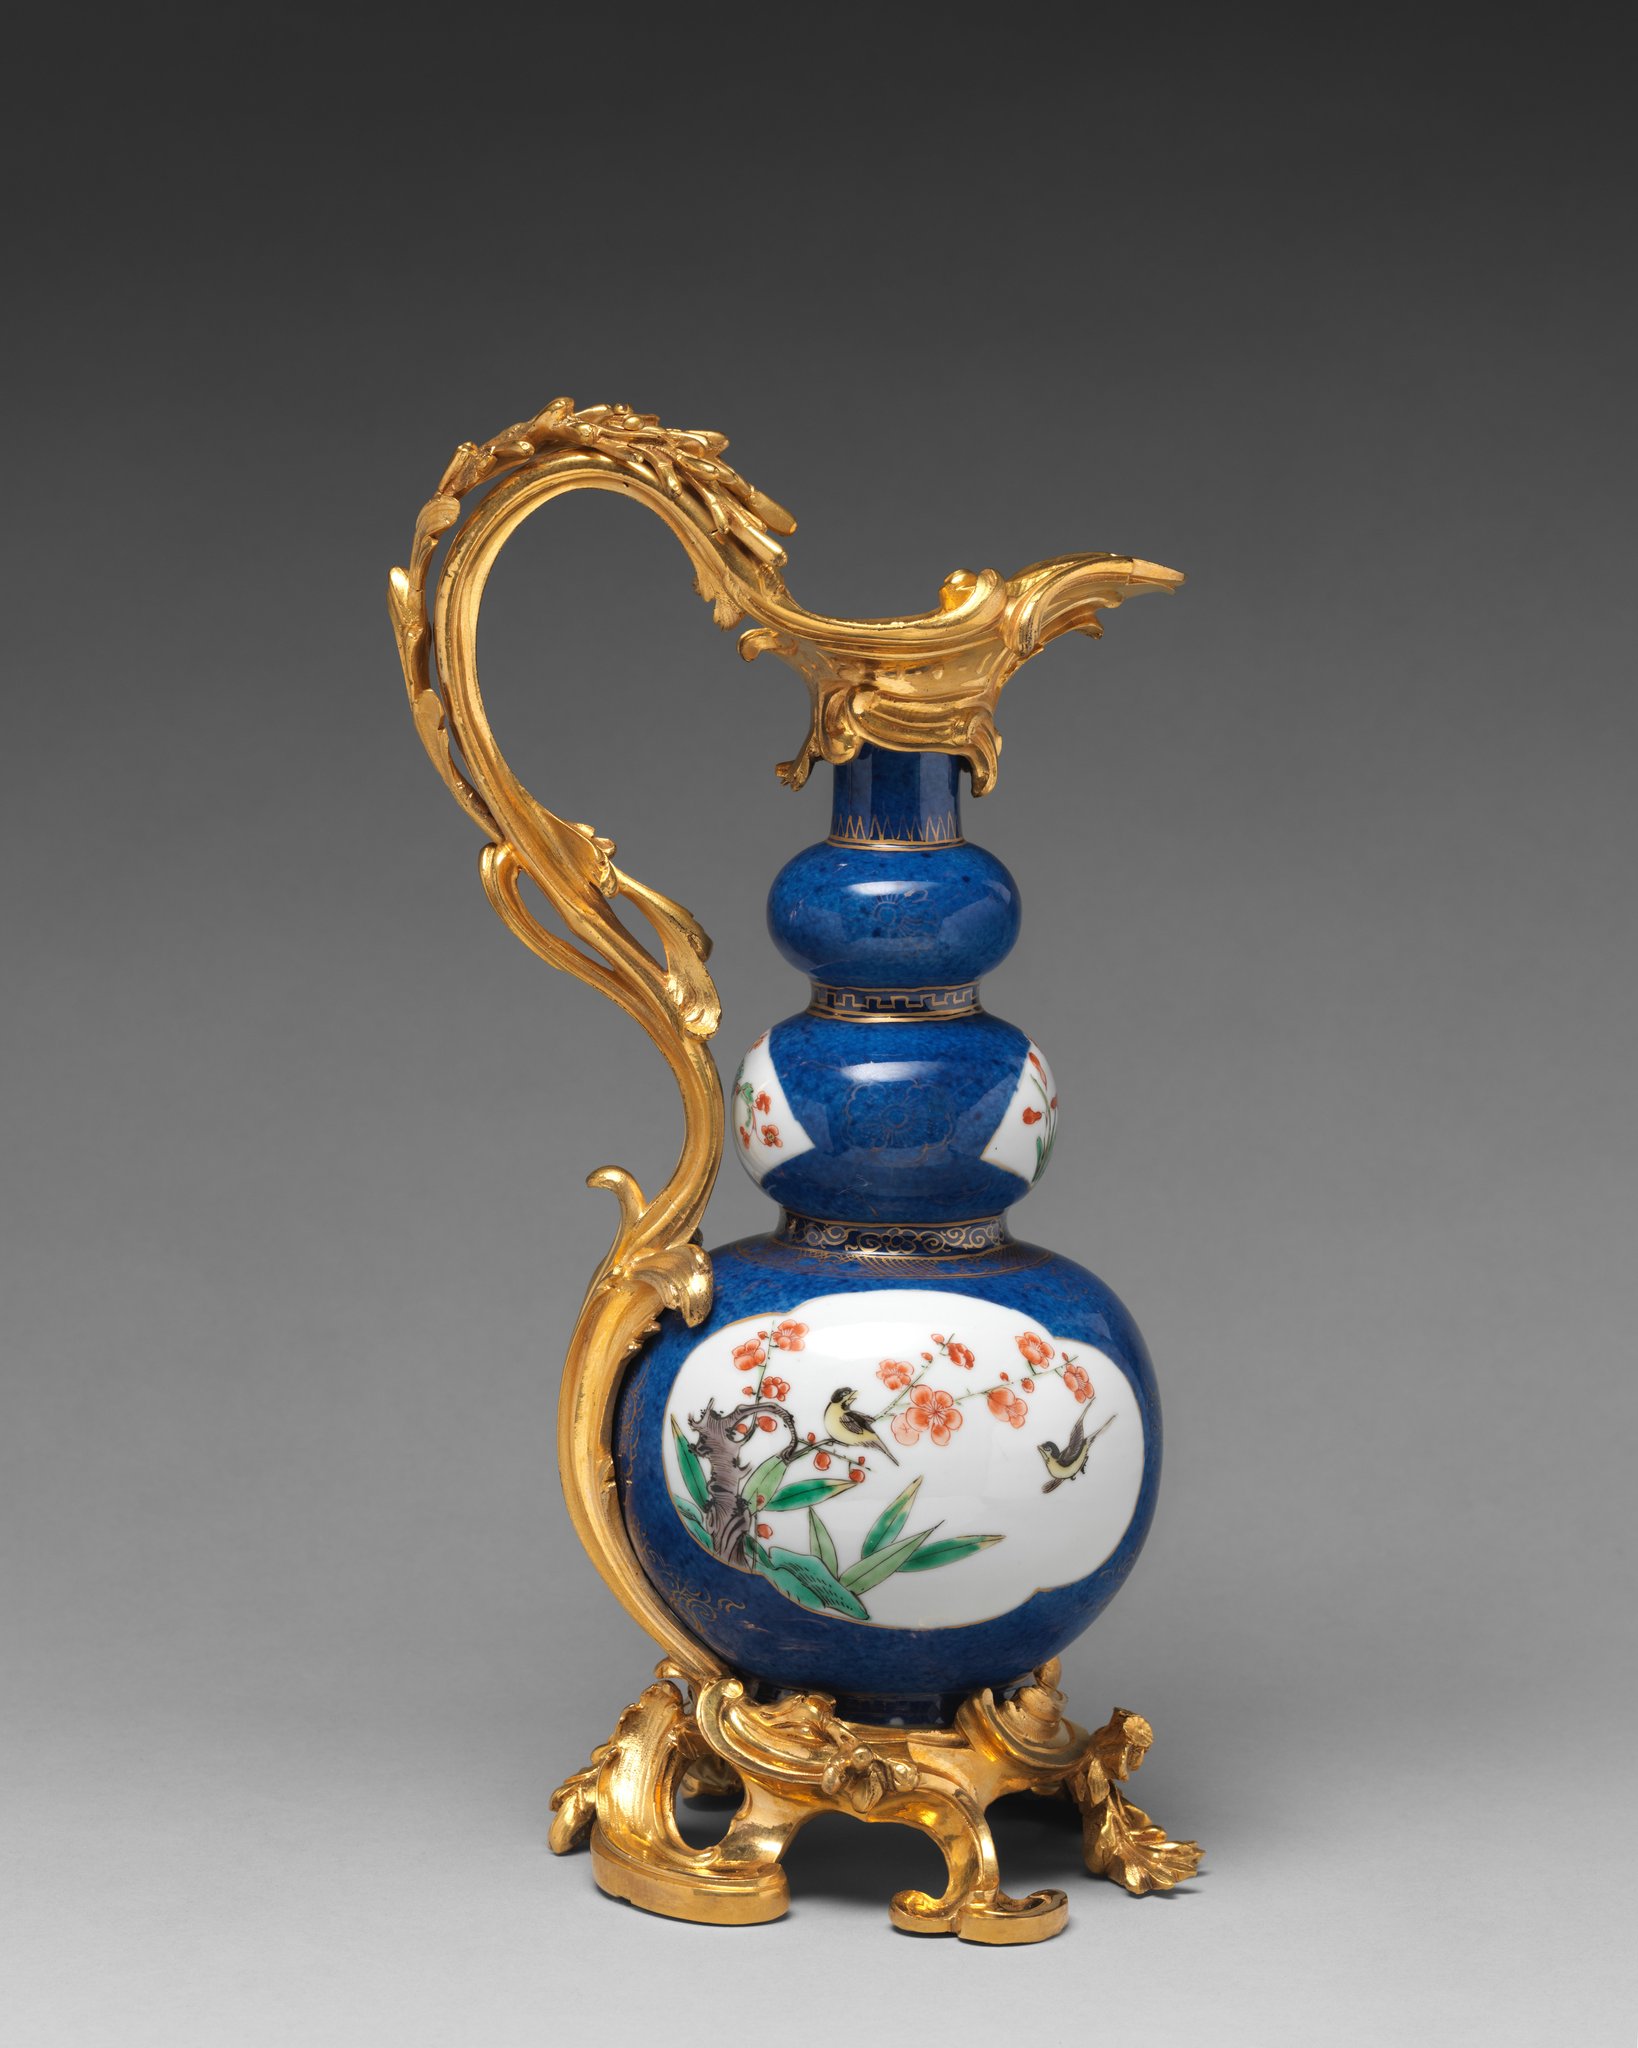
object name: vase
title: Triple gourd vase (one of a pair)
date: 1701-1800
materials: gilt bronze, hard paste porcelain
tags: birds